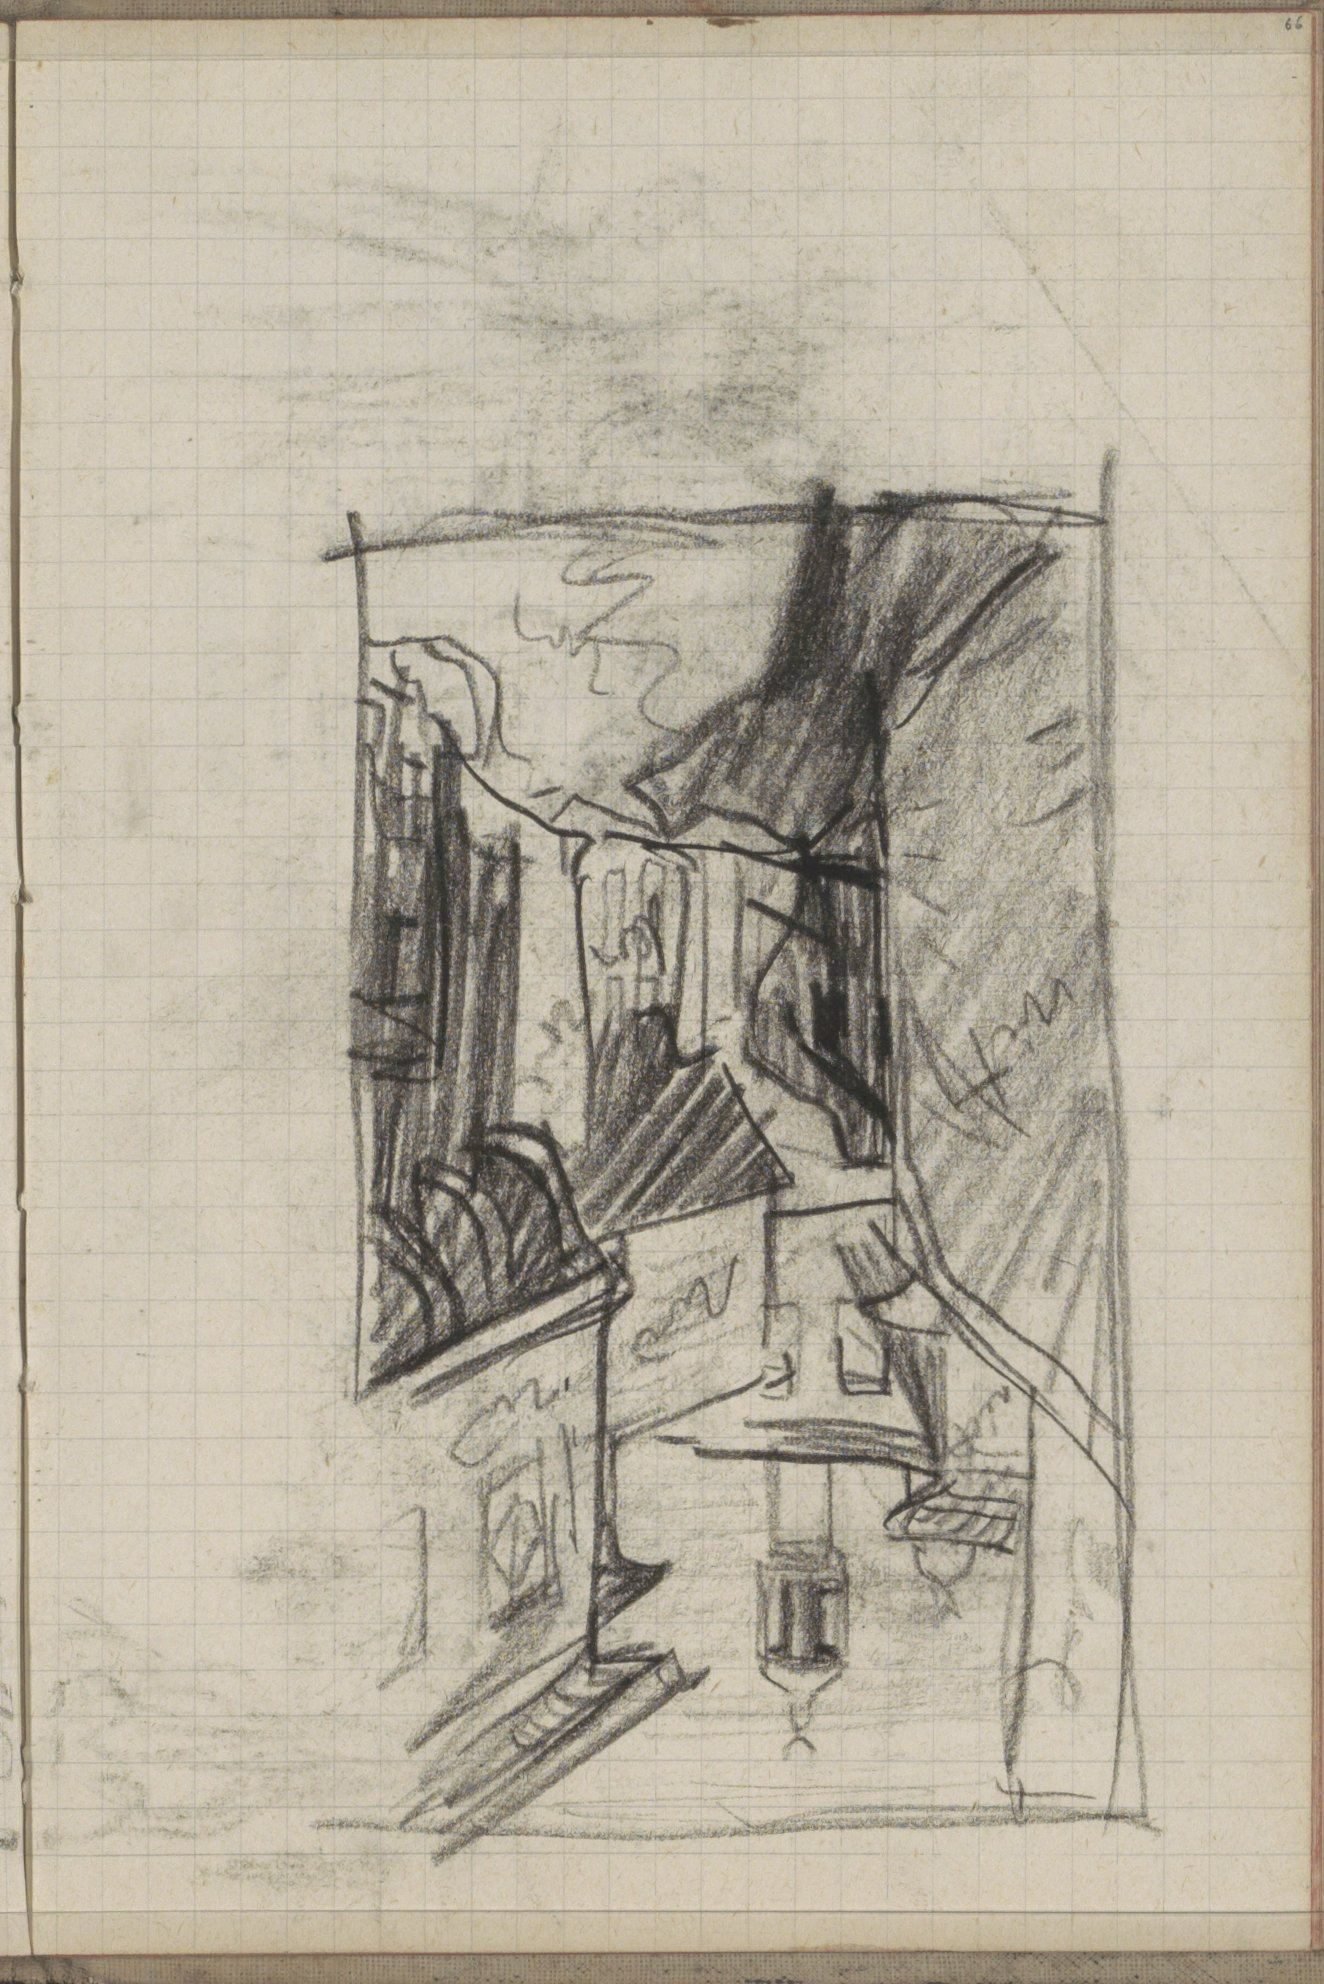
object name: sketchbook leaf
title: Gezicht op een straat met een minaret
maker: marius bauer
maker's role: draughtsman, print maker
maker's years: 1867-1932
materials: chalk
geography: istanbul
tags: temple, shrine ~ islam, mohammedanism, street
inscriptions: kleurnotitie, handgeschreven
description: Pagina 66 uit een schetsboek met 54 bladen.